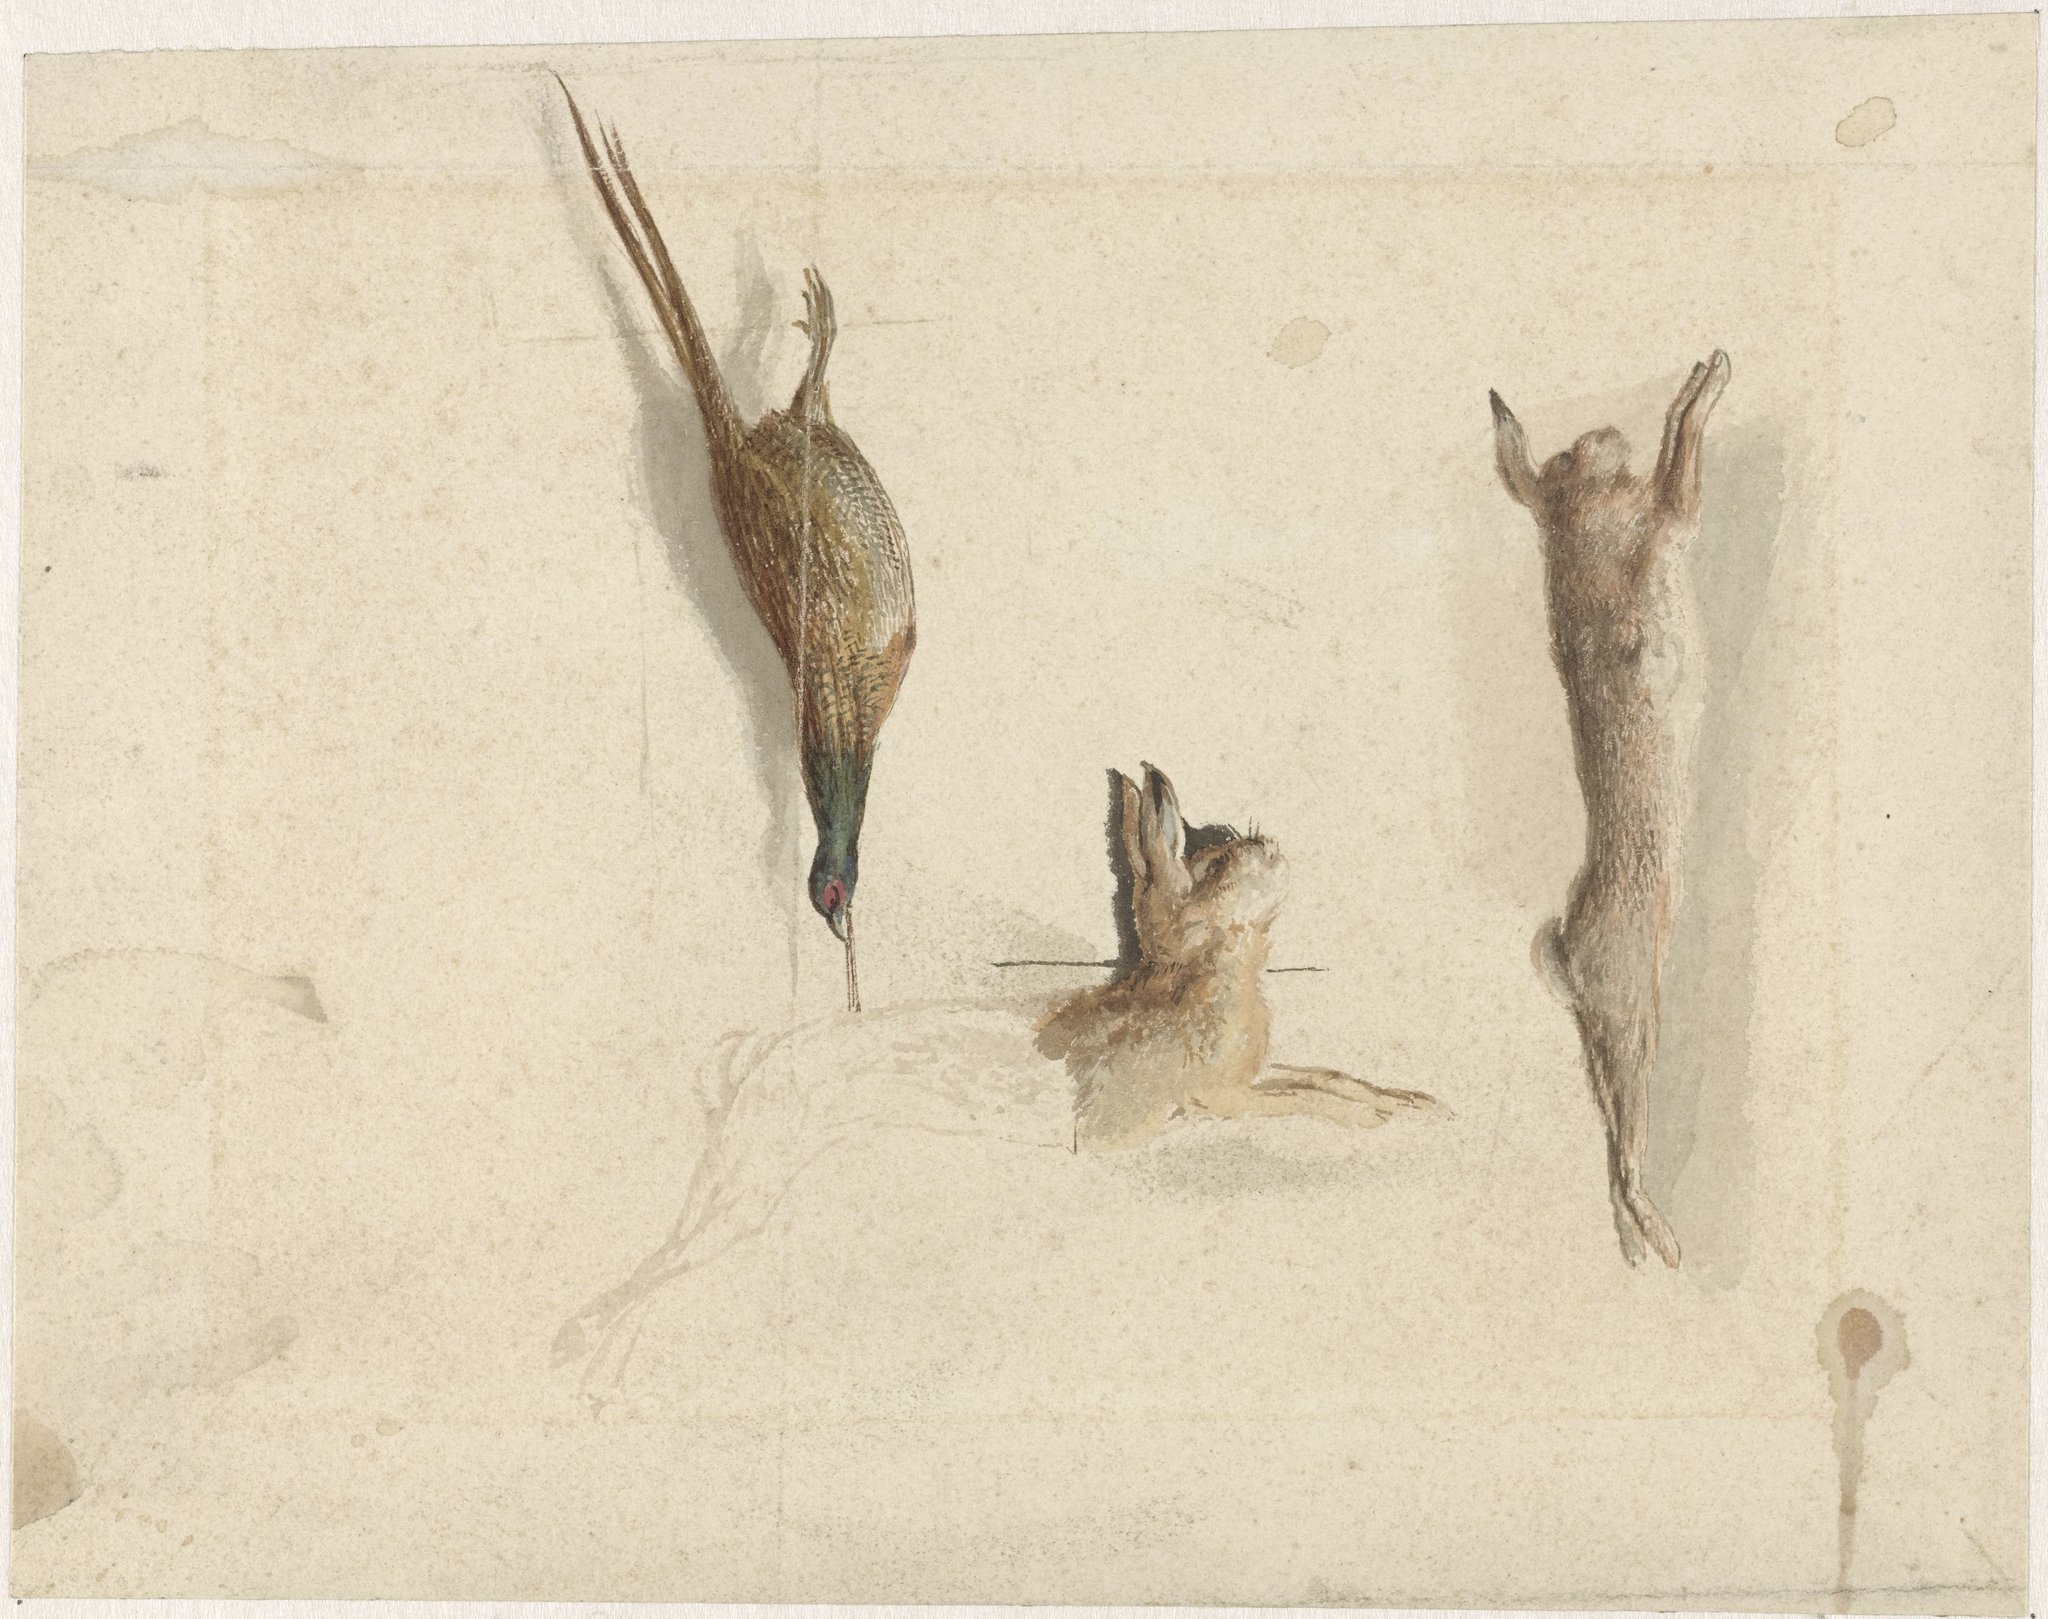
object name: watercolor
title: Dode fazant en twee dode hazen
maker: reinier craeyvanger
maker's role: draughtsman, print maker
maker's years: 1812-1880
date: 1822-1880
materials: paper, watercolor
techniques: brush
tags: rodents: hare, walker and runner birds: pheasant, spoils of the hunt, game, venison